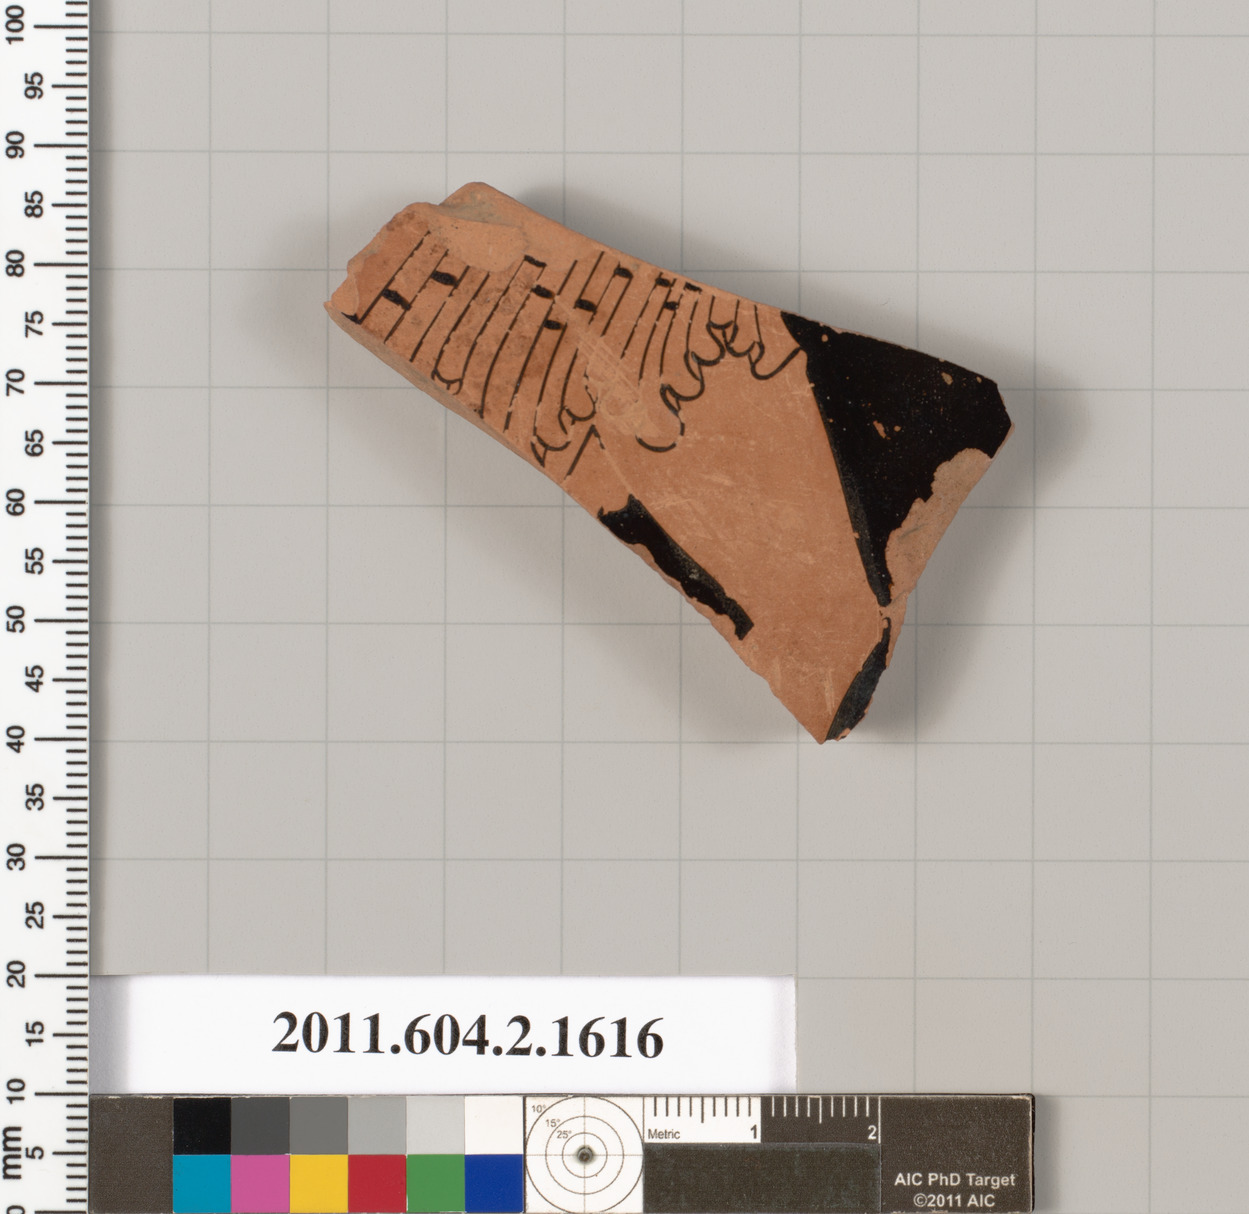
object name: skyphos fragment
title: Terracotta fragment of a skyphos (deep drinking cup)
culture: greek, attic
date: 490-470 BCE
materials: terracotta